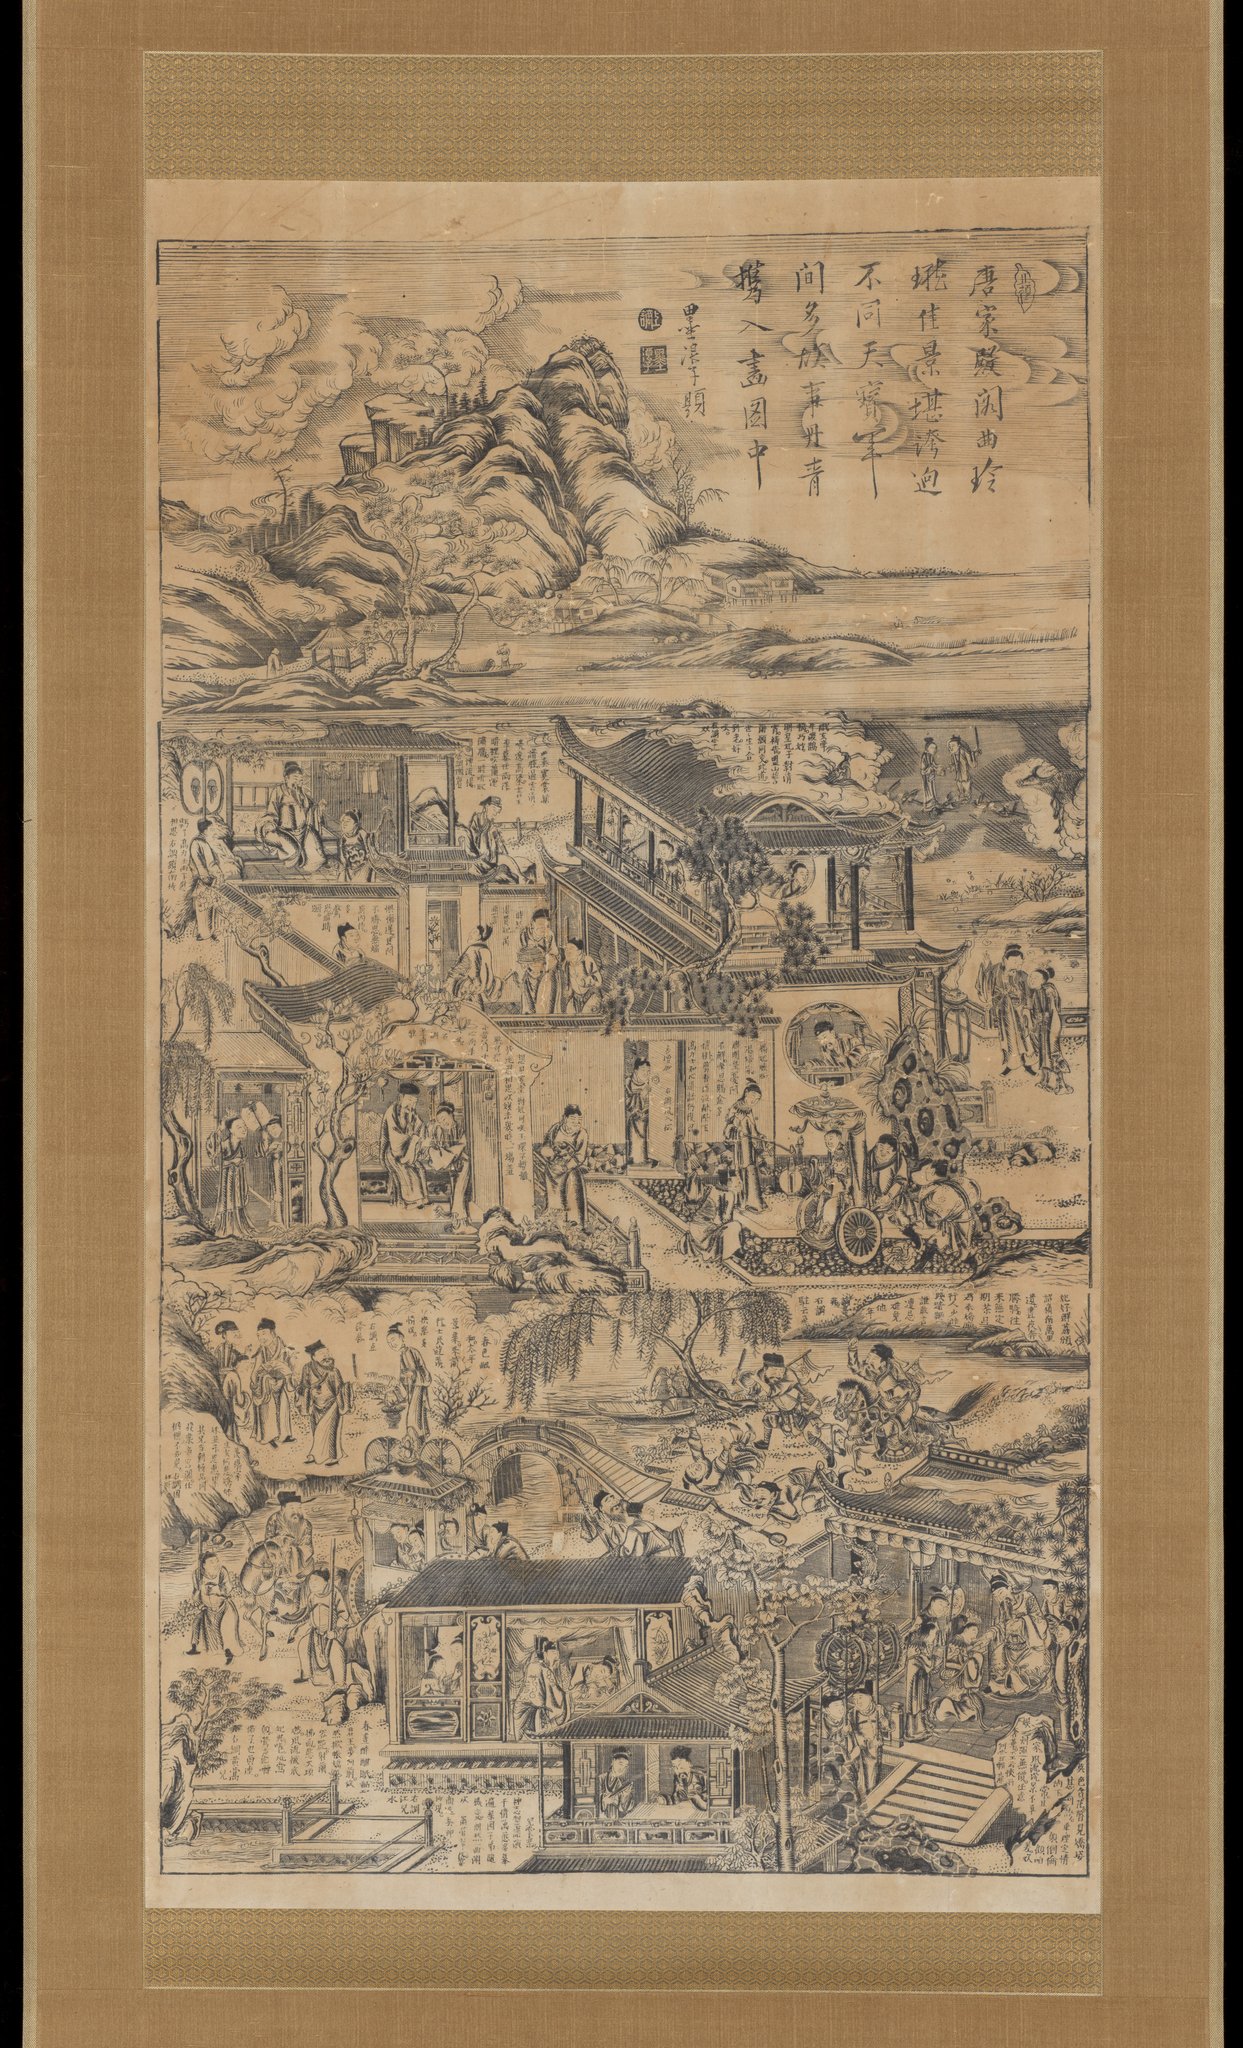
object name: print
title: Yang Guifei and the Tang Emperor Minghuang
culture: chinese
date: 1736-1795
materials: ink, paper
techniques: woodblock print